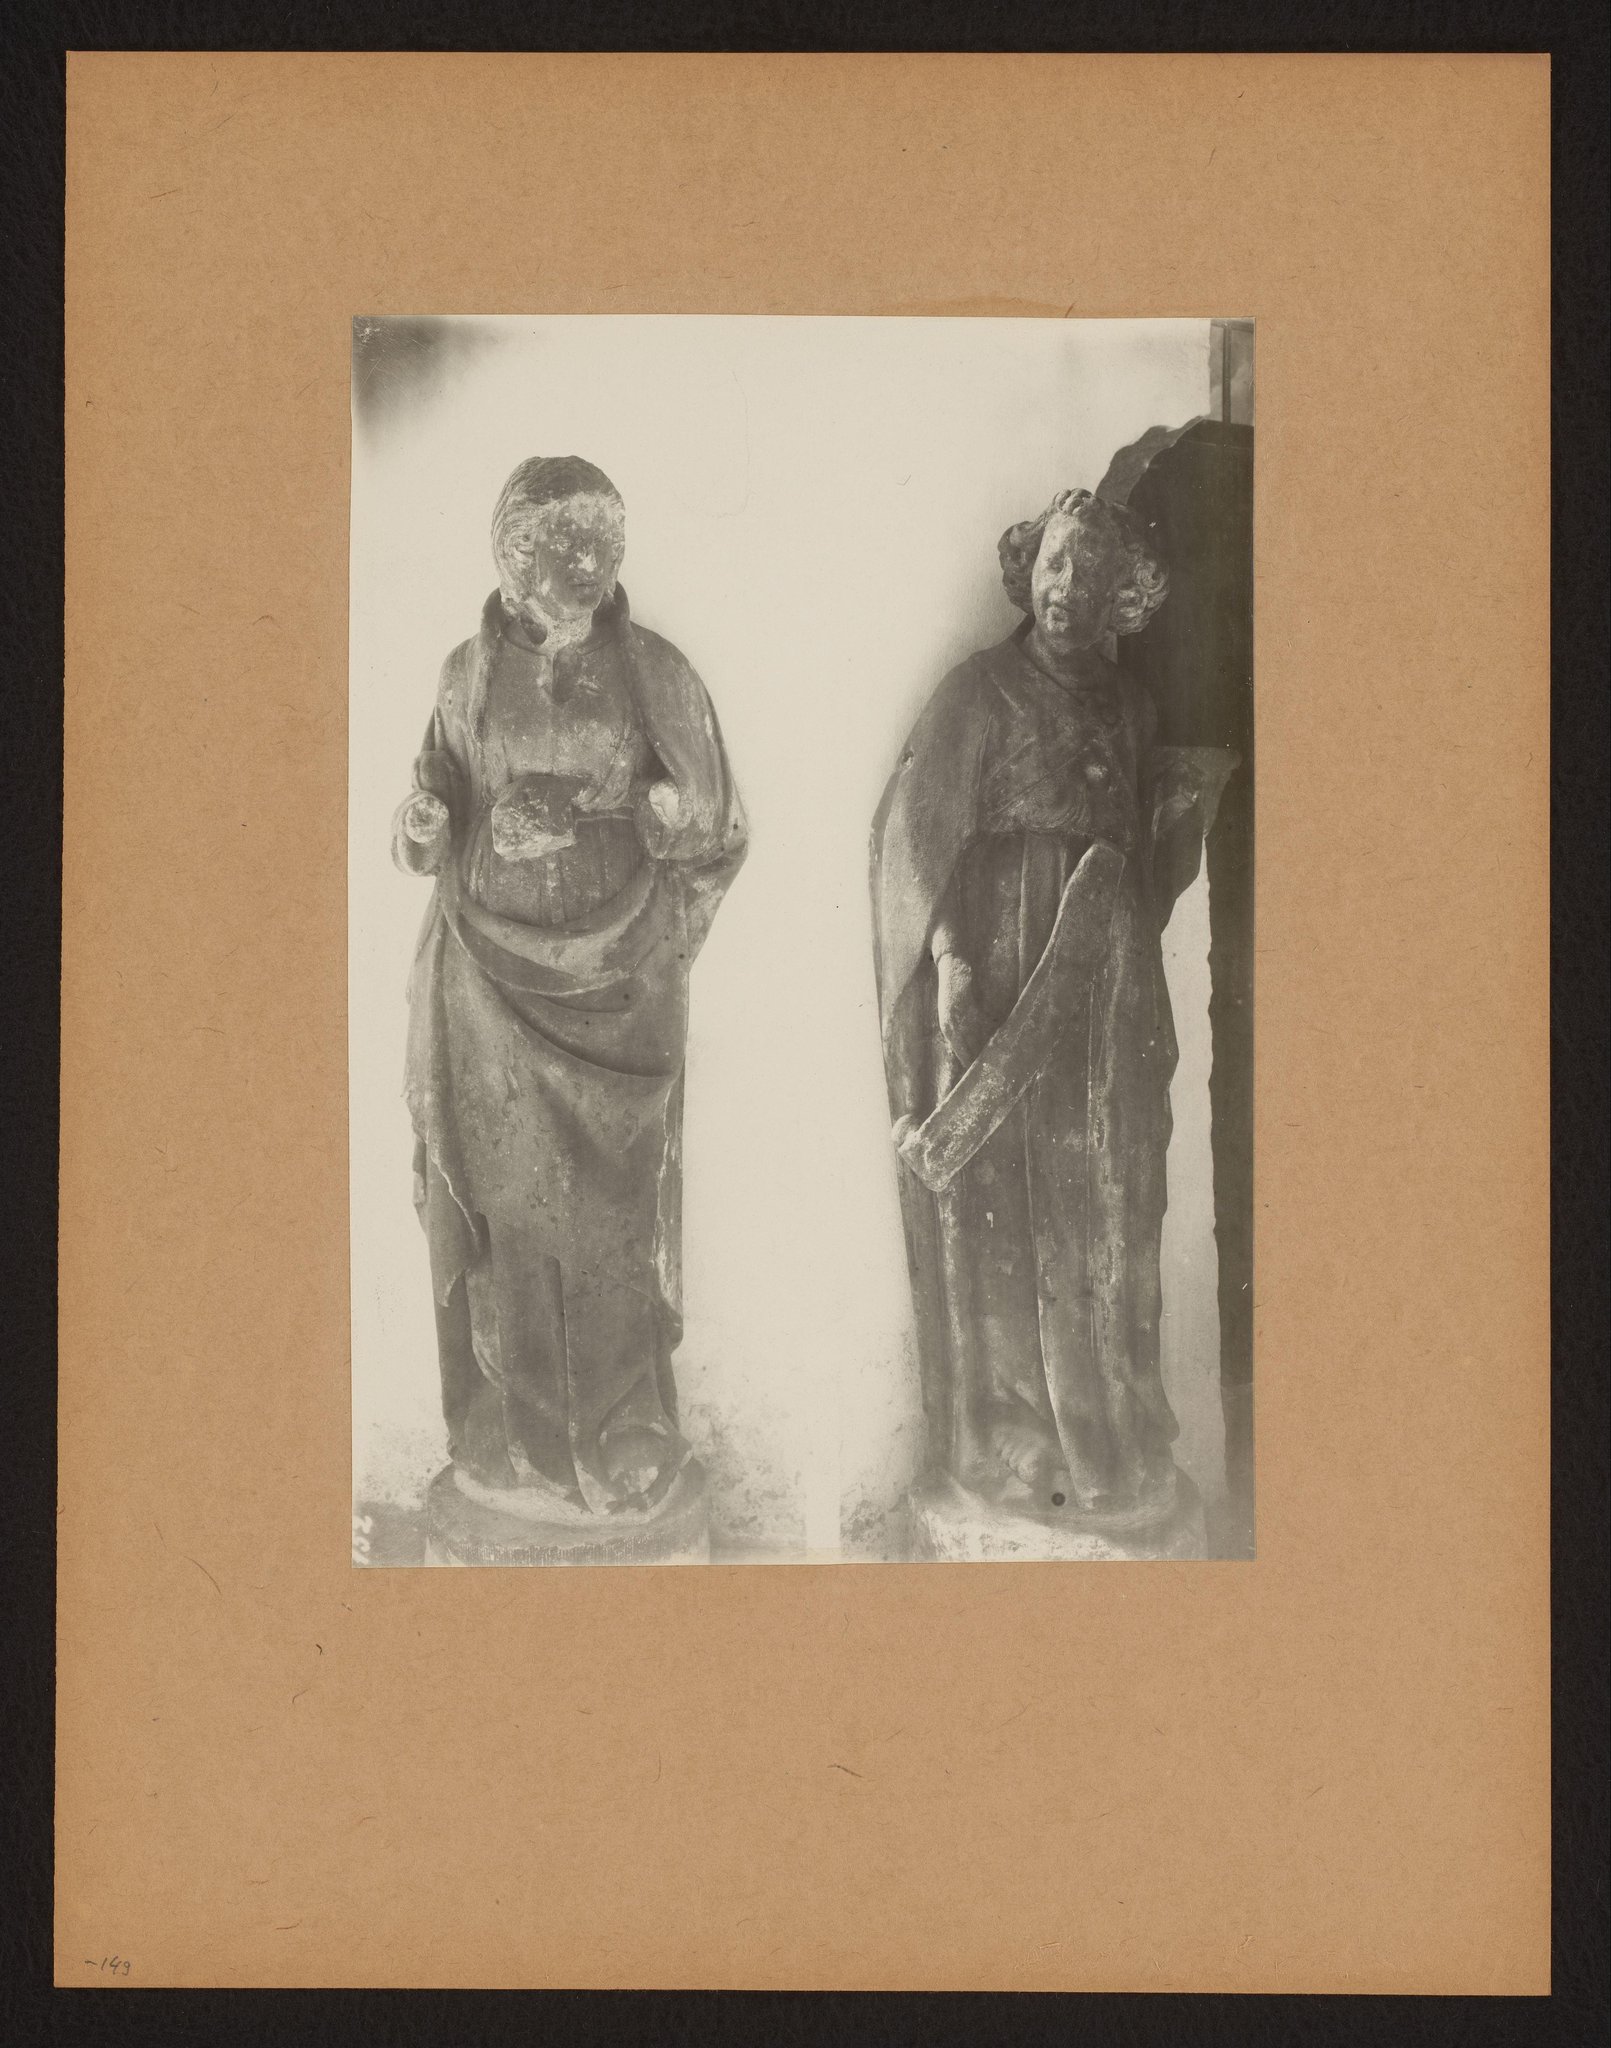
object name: photograph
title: Beeldhouwkunst in de kloostergang van de dom van Bamberg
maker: Anonymous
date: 1900-1920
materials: paper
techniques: gelatin silver print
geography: bamberg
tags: interior of church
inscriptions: number: ‘152’